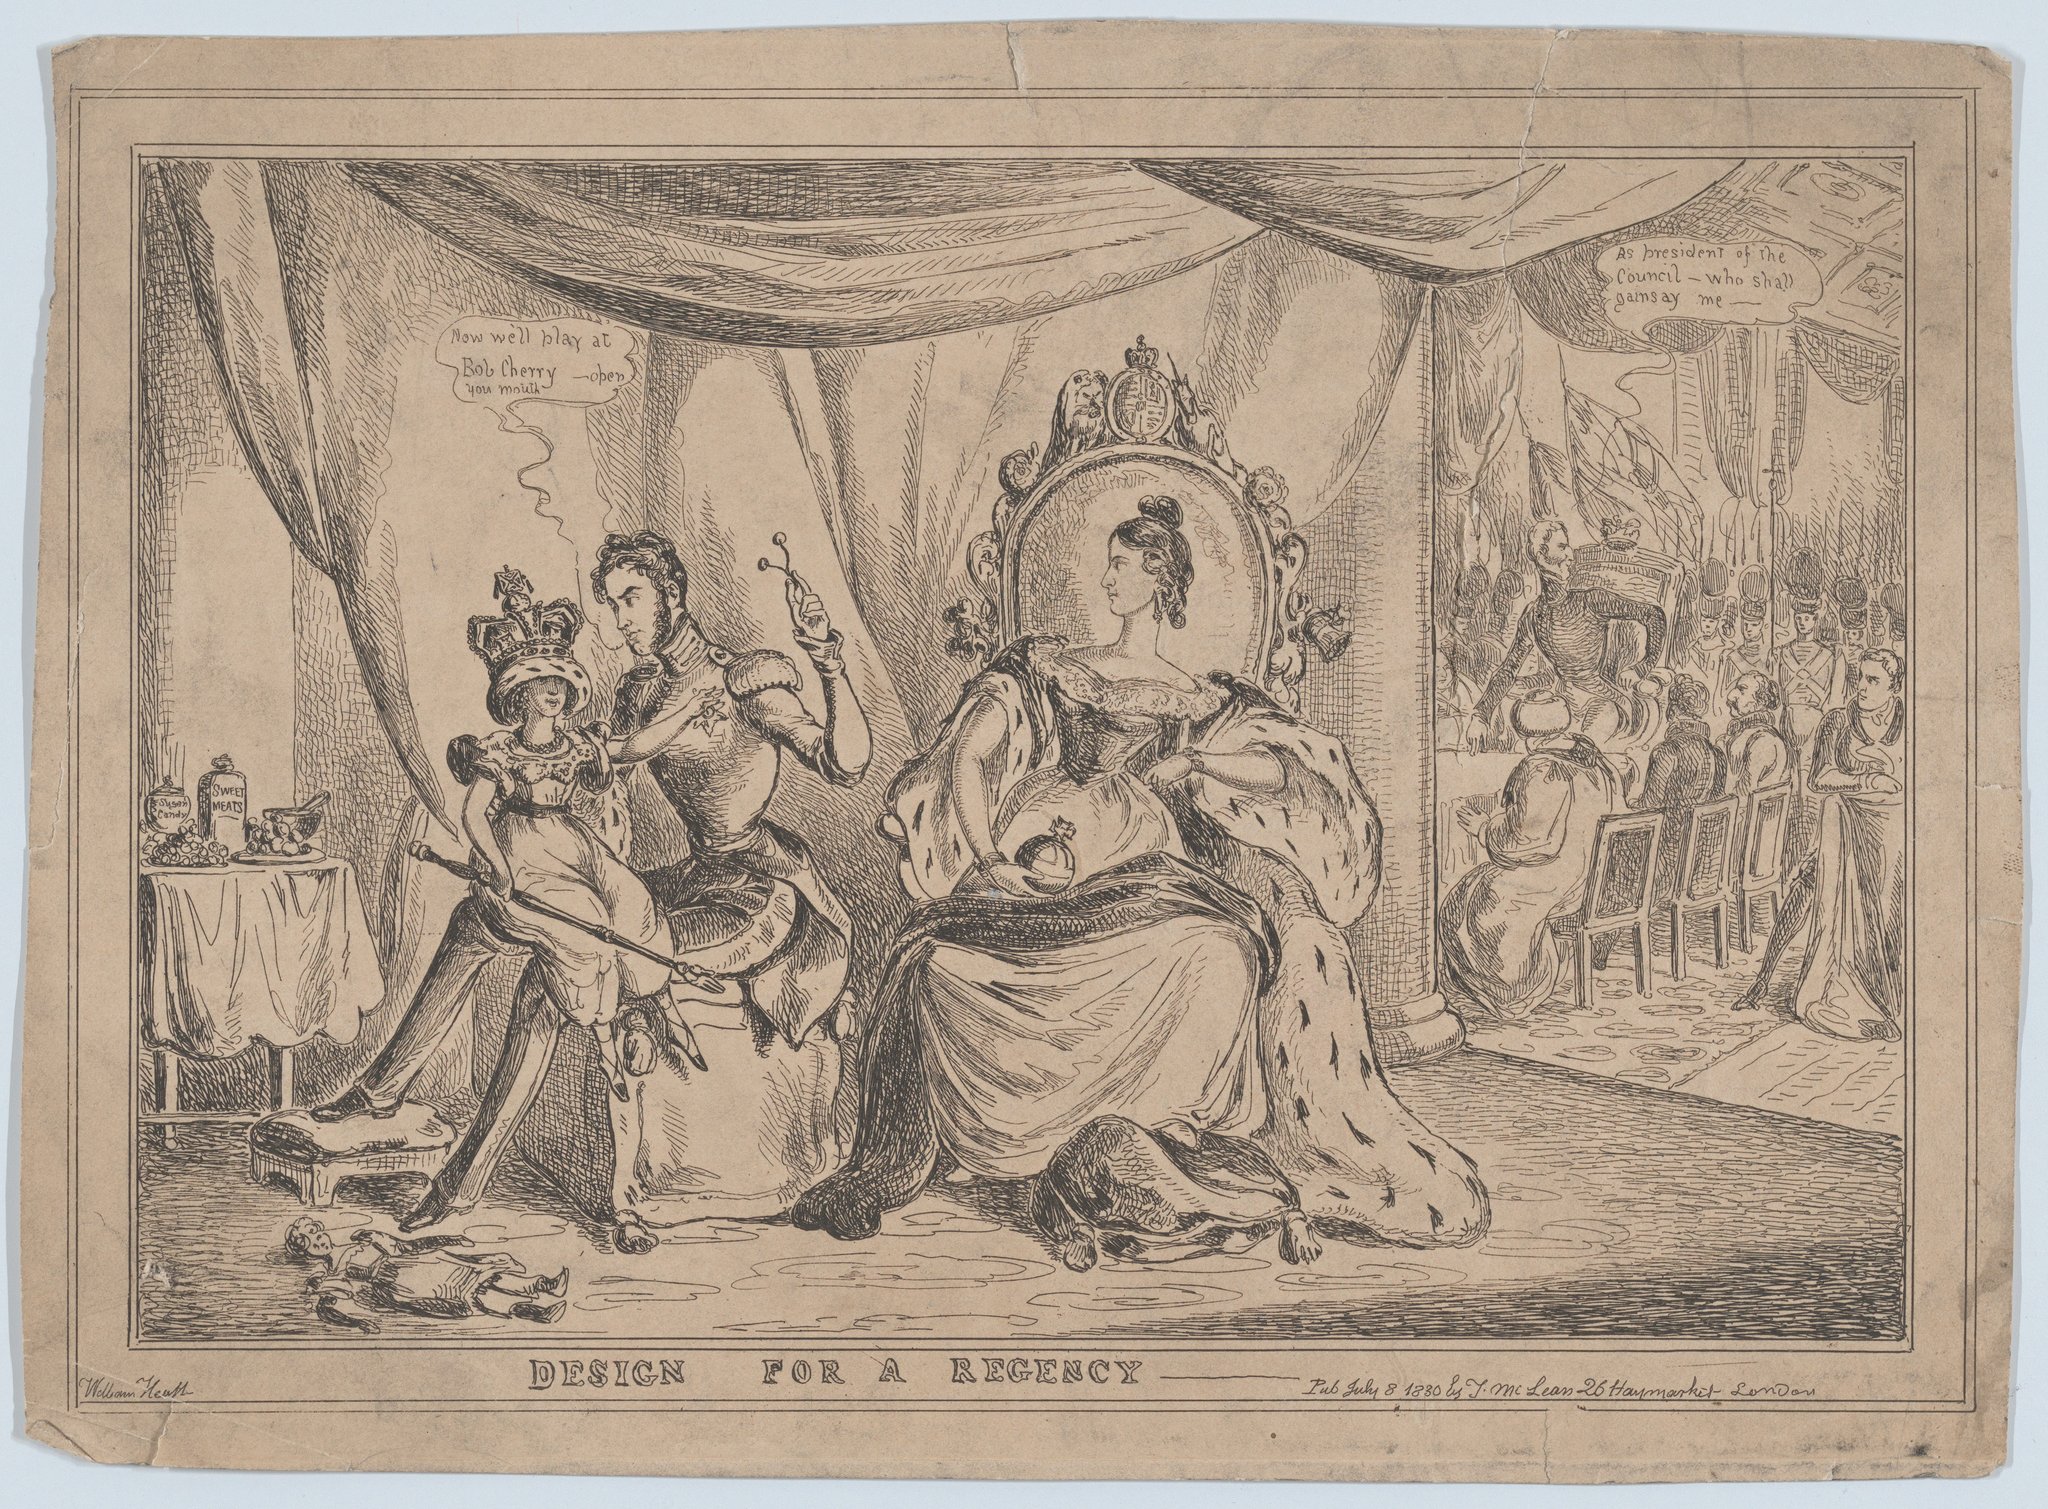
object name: print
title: Design for a Regency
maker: william heath ('paul pry')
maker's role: artist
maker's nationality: british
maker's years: 1794-1840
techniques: etching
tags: interiors,children,men,women